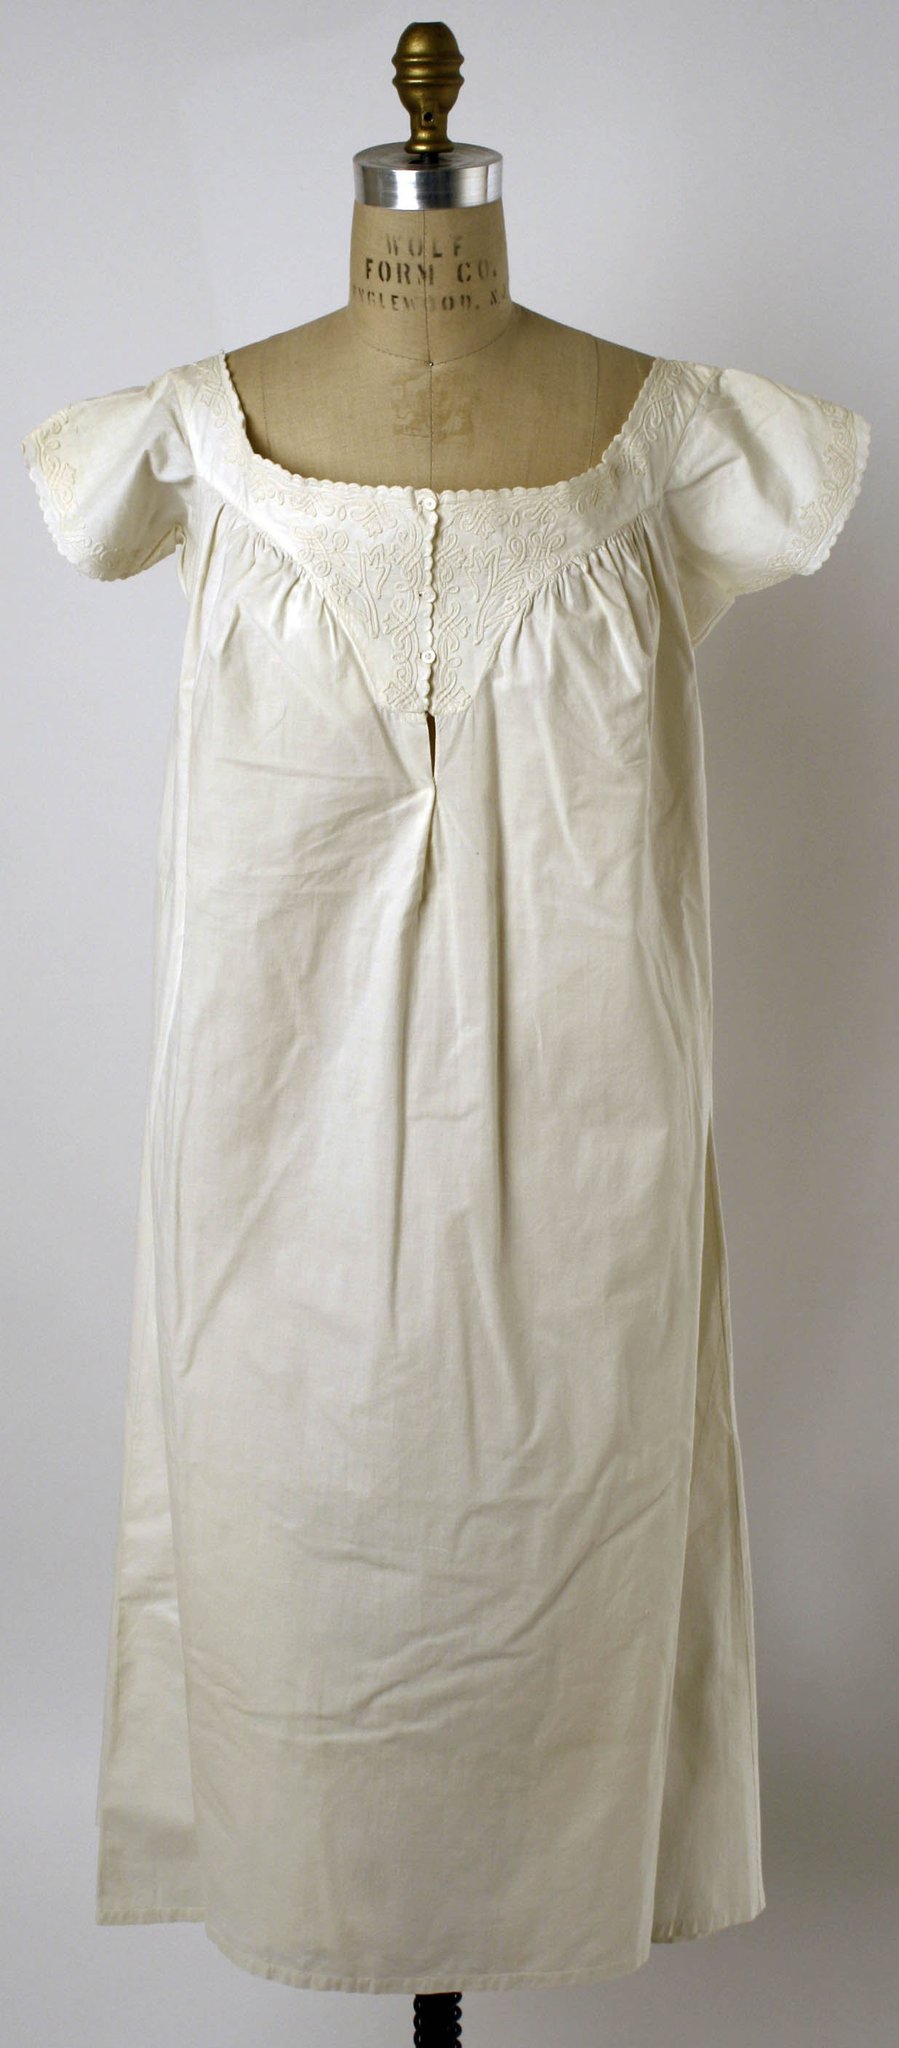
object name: chemise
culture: american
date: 1856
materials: cotton